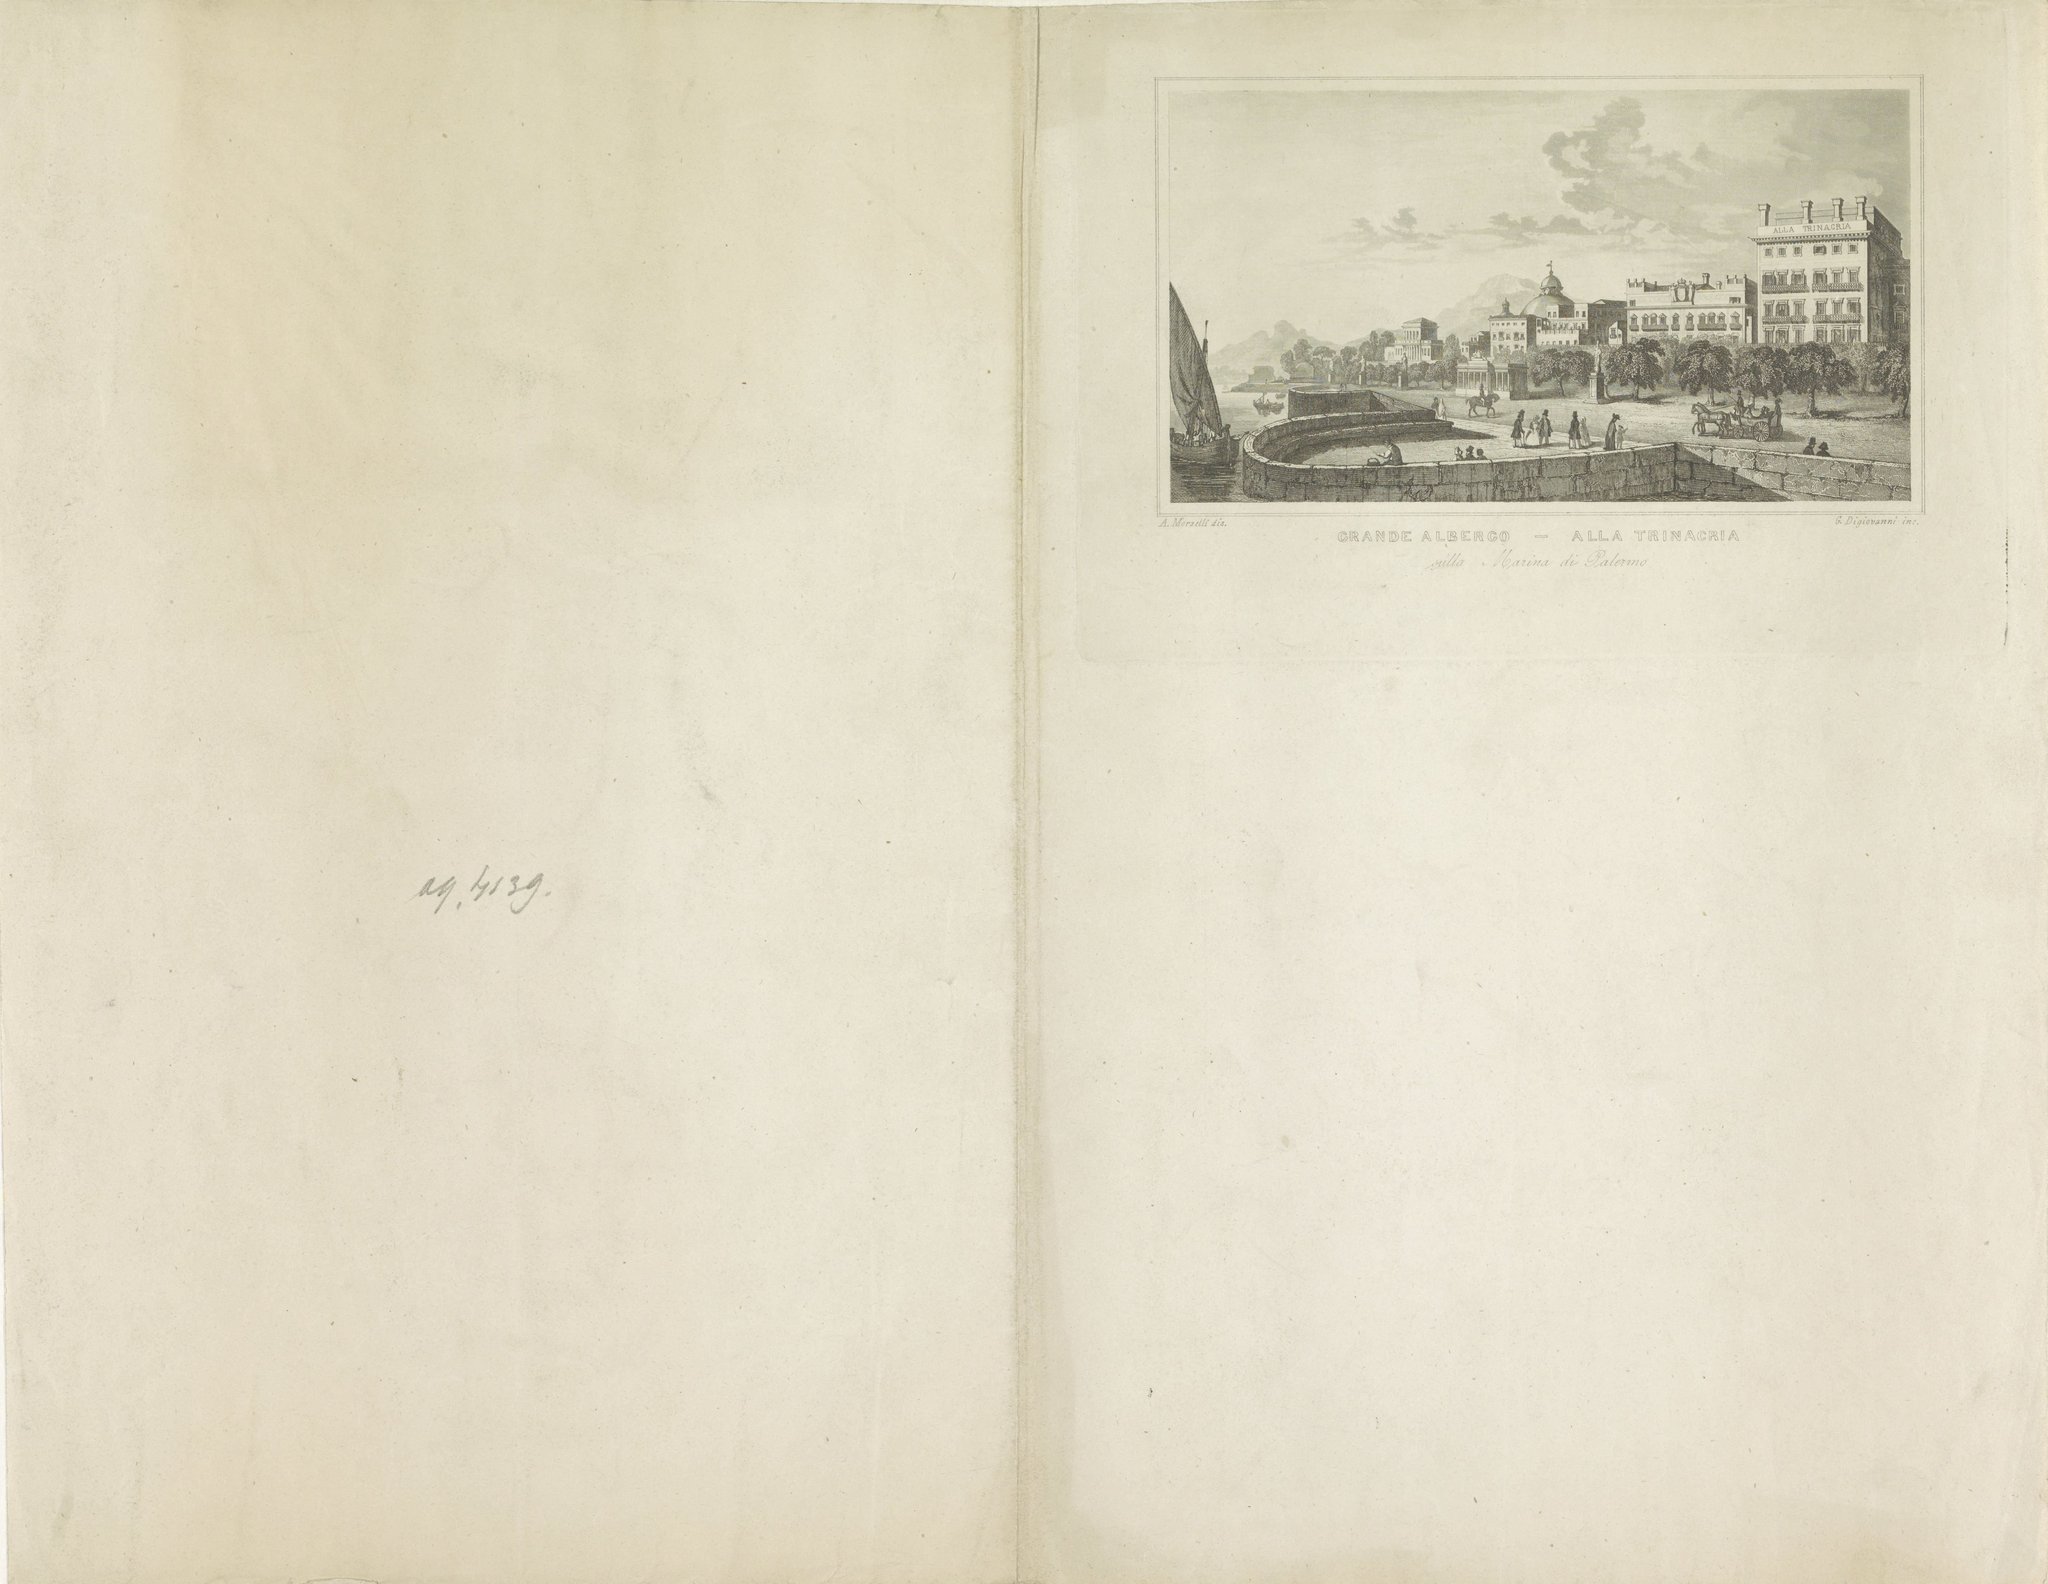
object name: print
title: Grand Hotel Trinacria in Palermo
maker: g. di giovanni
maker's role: print maker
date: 1800-1899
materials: paper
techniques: etching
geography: italy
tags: hotel, hostelry, inn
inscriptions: collector's mark: Lugt 2228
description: Gezicht op het Grand Hotel Trinacria aan de kust in Palermo.